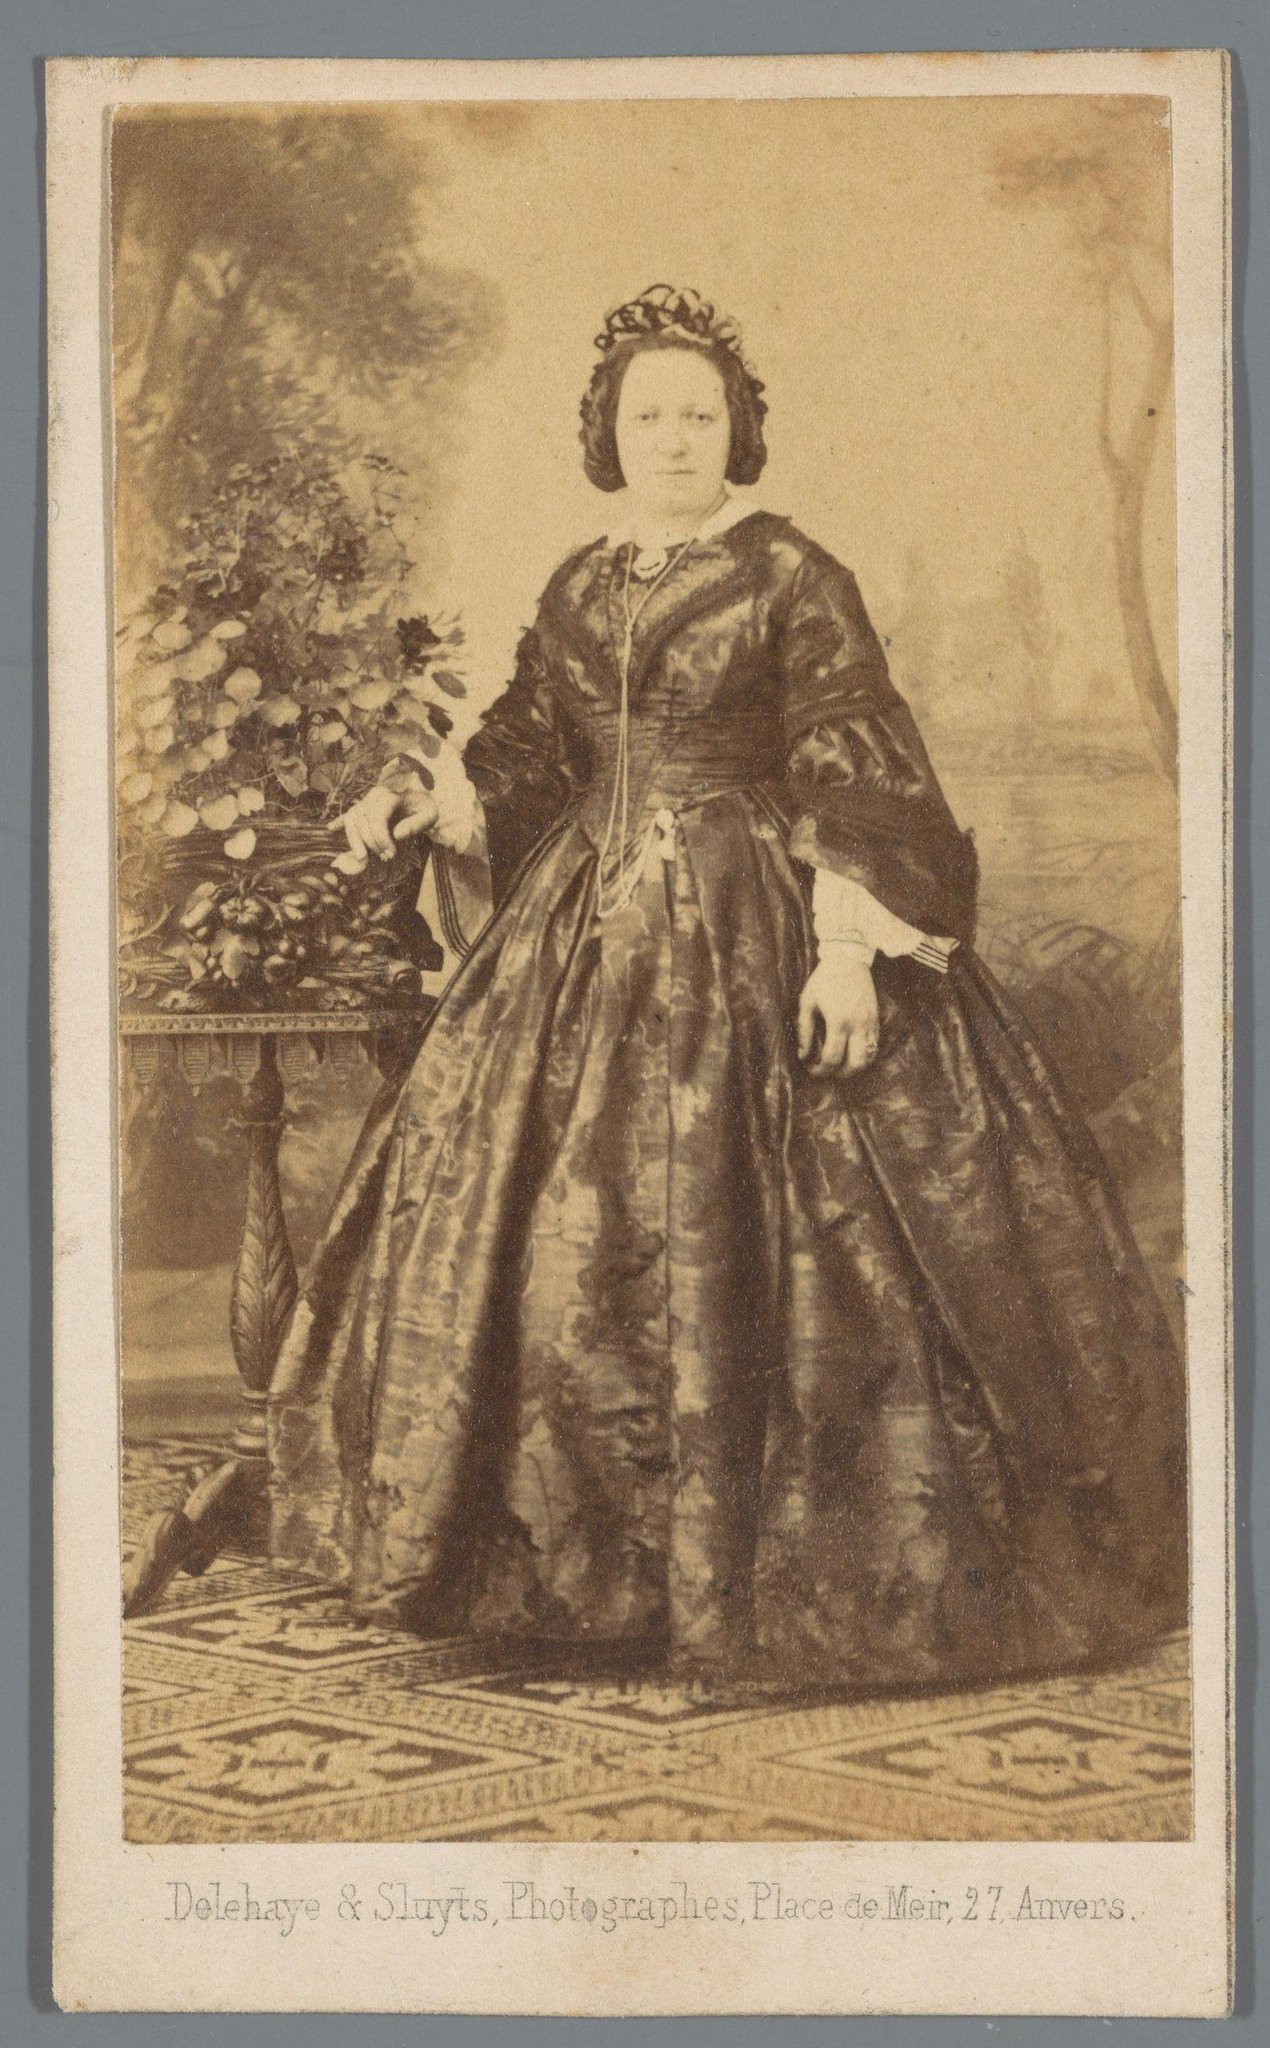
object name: carte de visite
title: Portret van een onbekende vrouw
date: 1862-1869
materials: cardboard, paper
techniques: albumen print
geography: antwerp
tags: adult woman, anonymous historical person portrayed, antwerp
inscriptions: inscription: ‘Delehaye & Sluyts, Photographes, Place de Meir, 27. Anvers.’